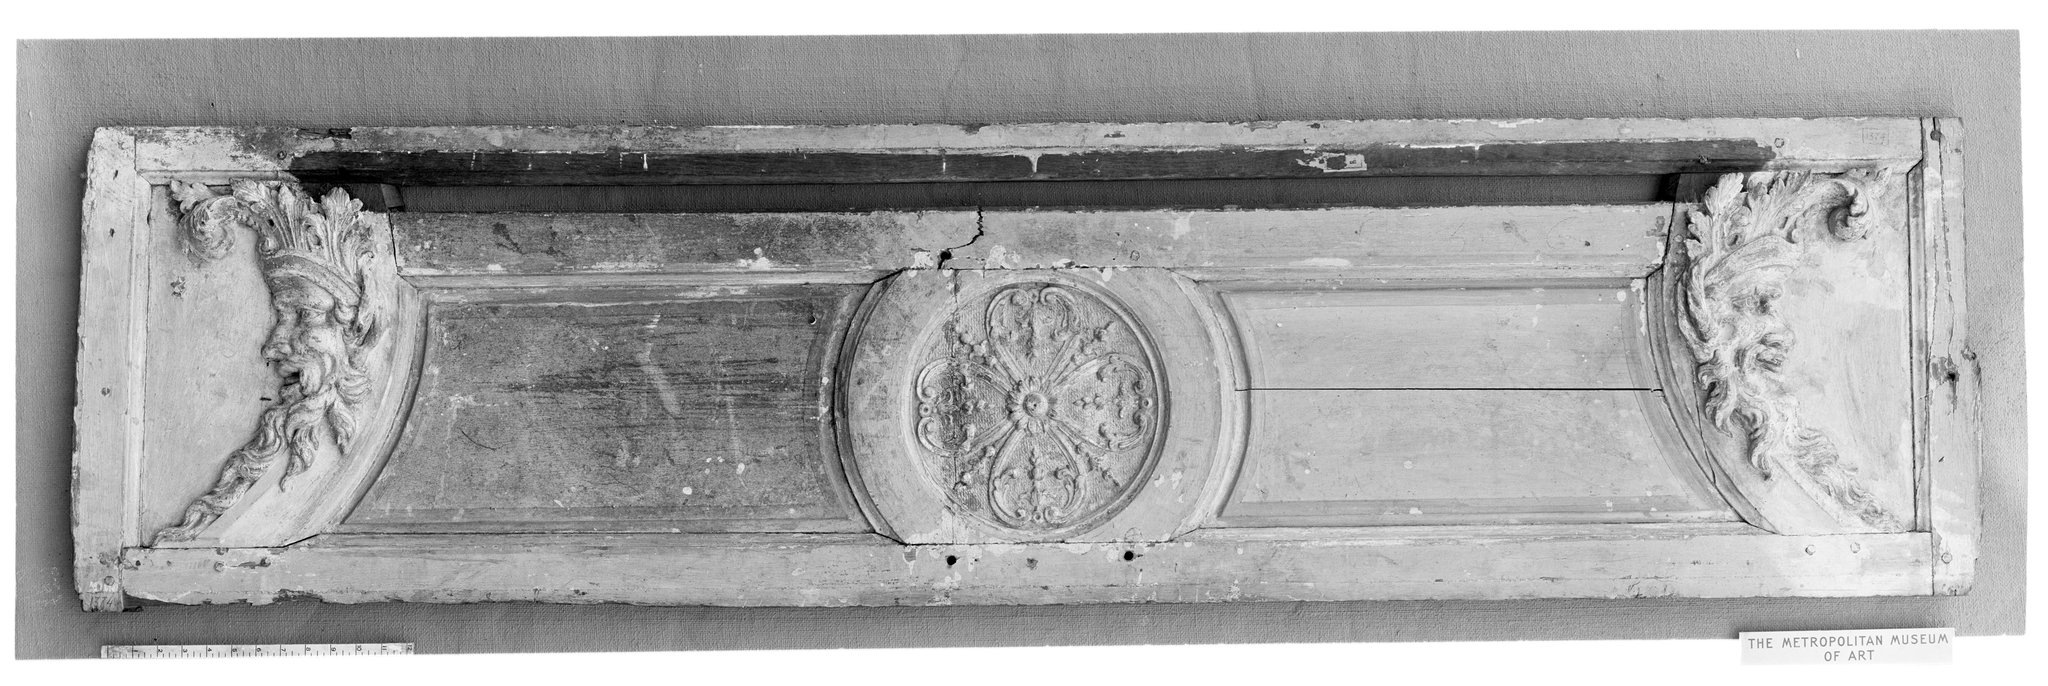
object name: panel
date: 1667-1700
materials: wood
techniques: carving, gilding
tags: faces